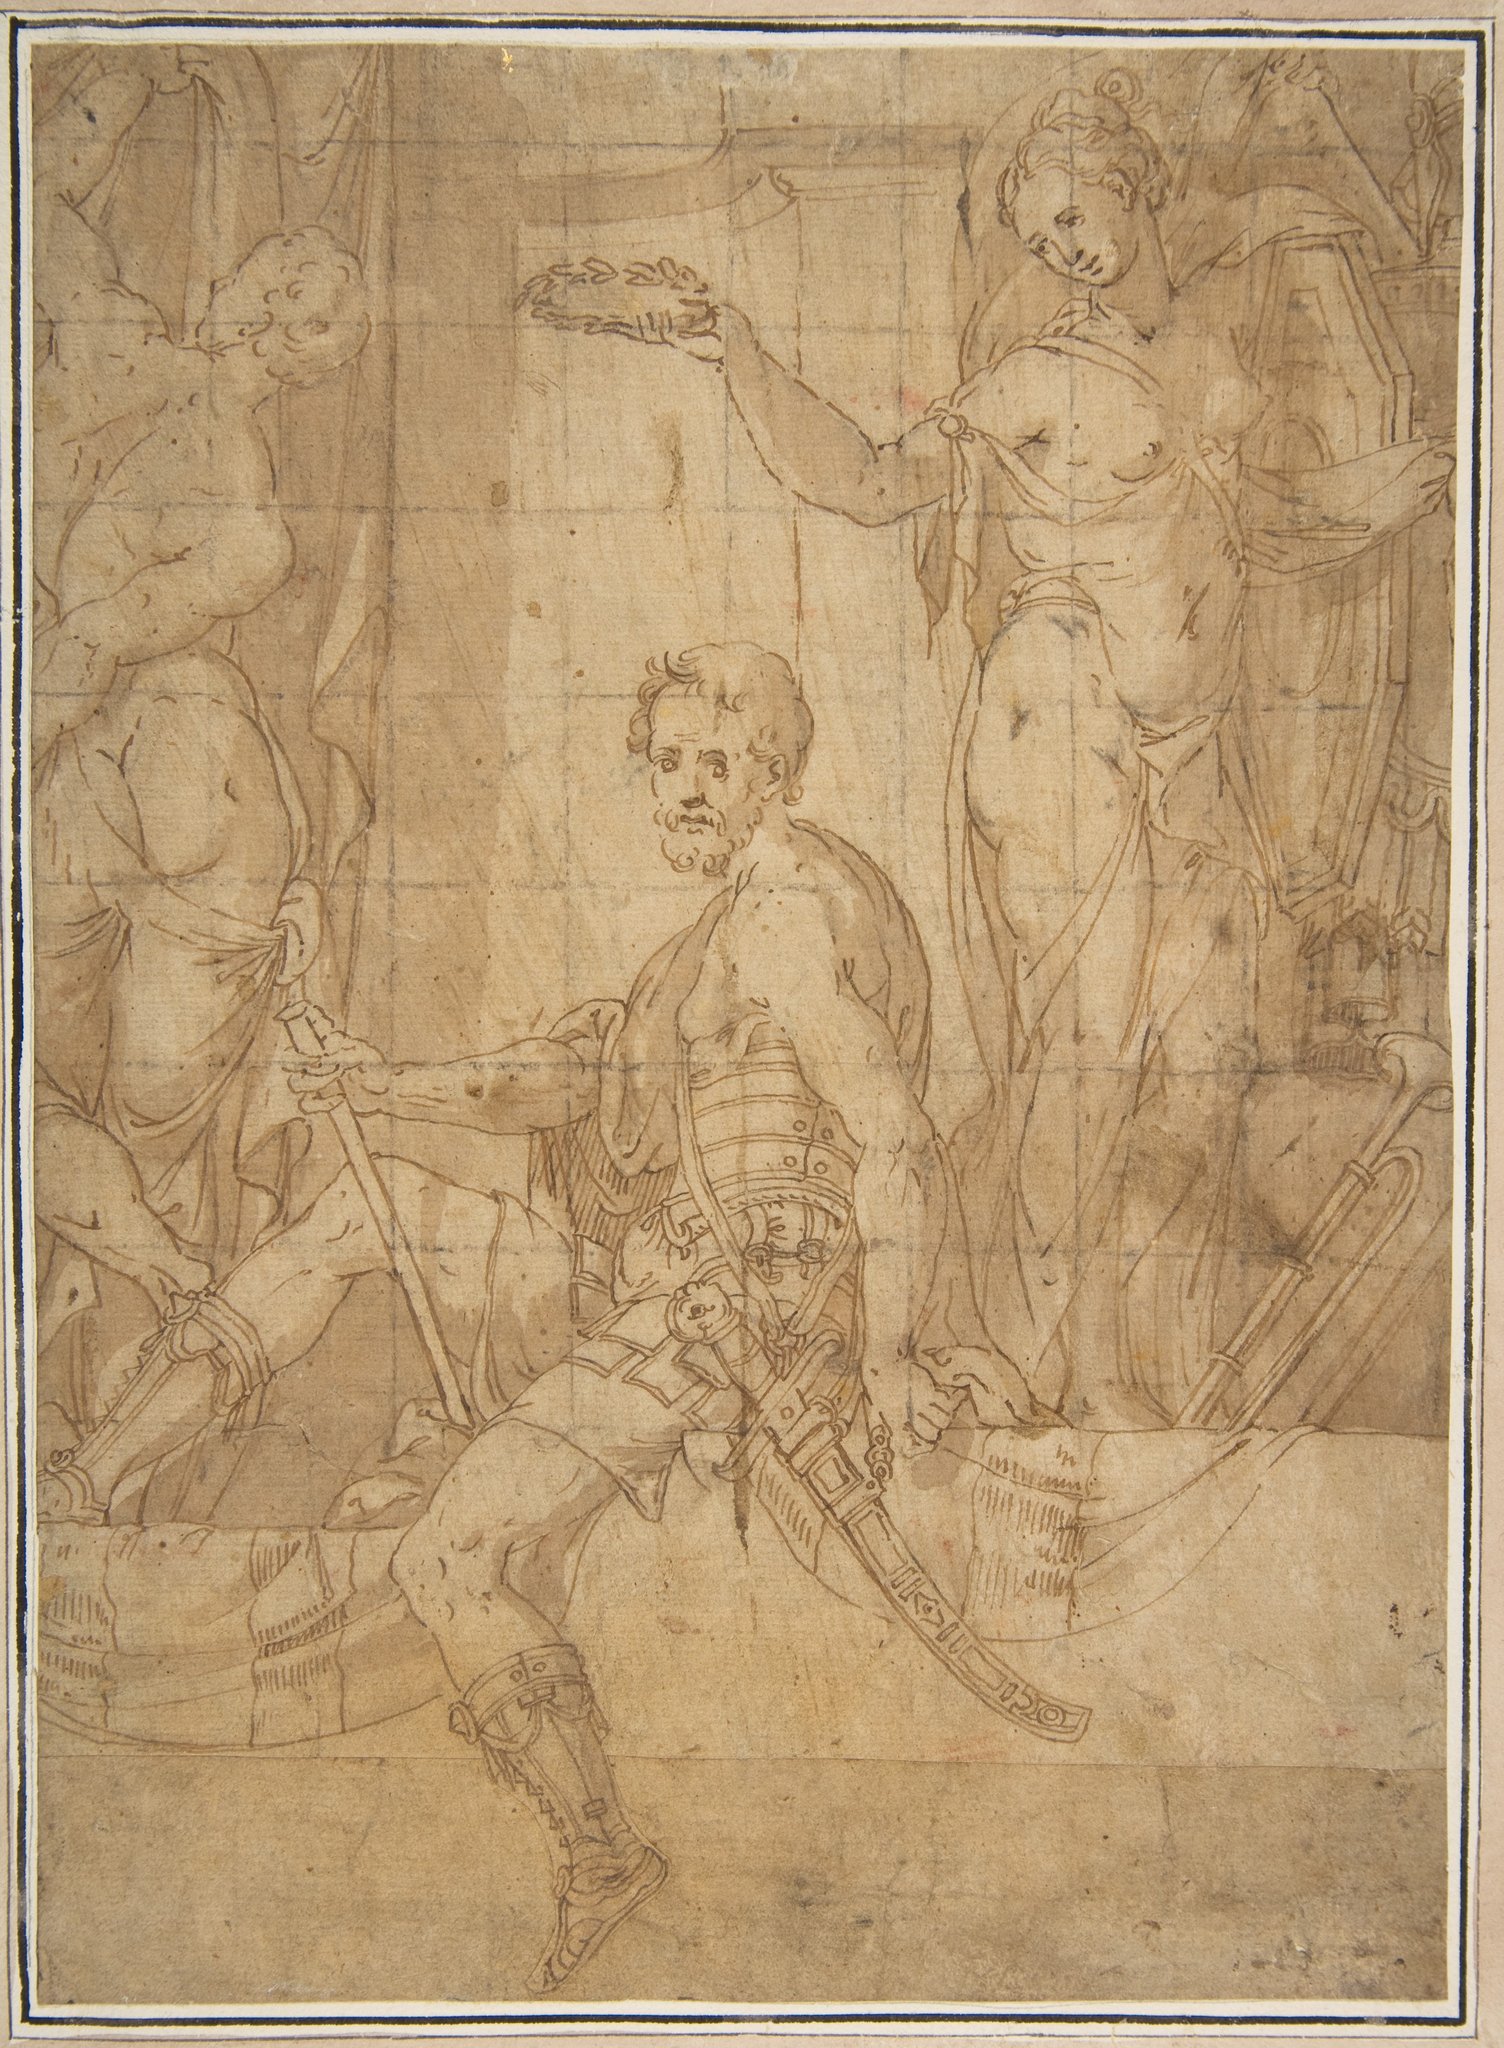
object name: drawing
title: Seated Warrior Between Two Figures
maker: giambattista zelotti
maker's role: artist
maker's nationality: italian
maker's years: 1526-1578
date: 1526-1578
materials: chalk, ink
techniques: pen, drawing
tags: soldiers,men,female nudes